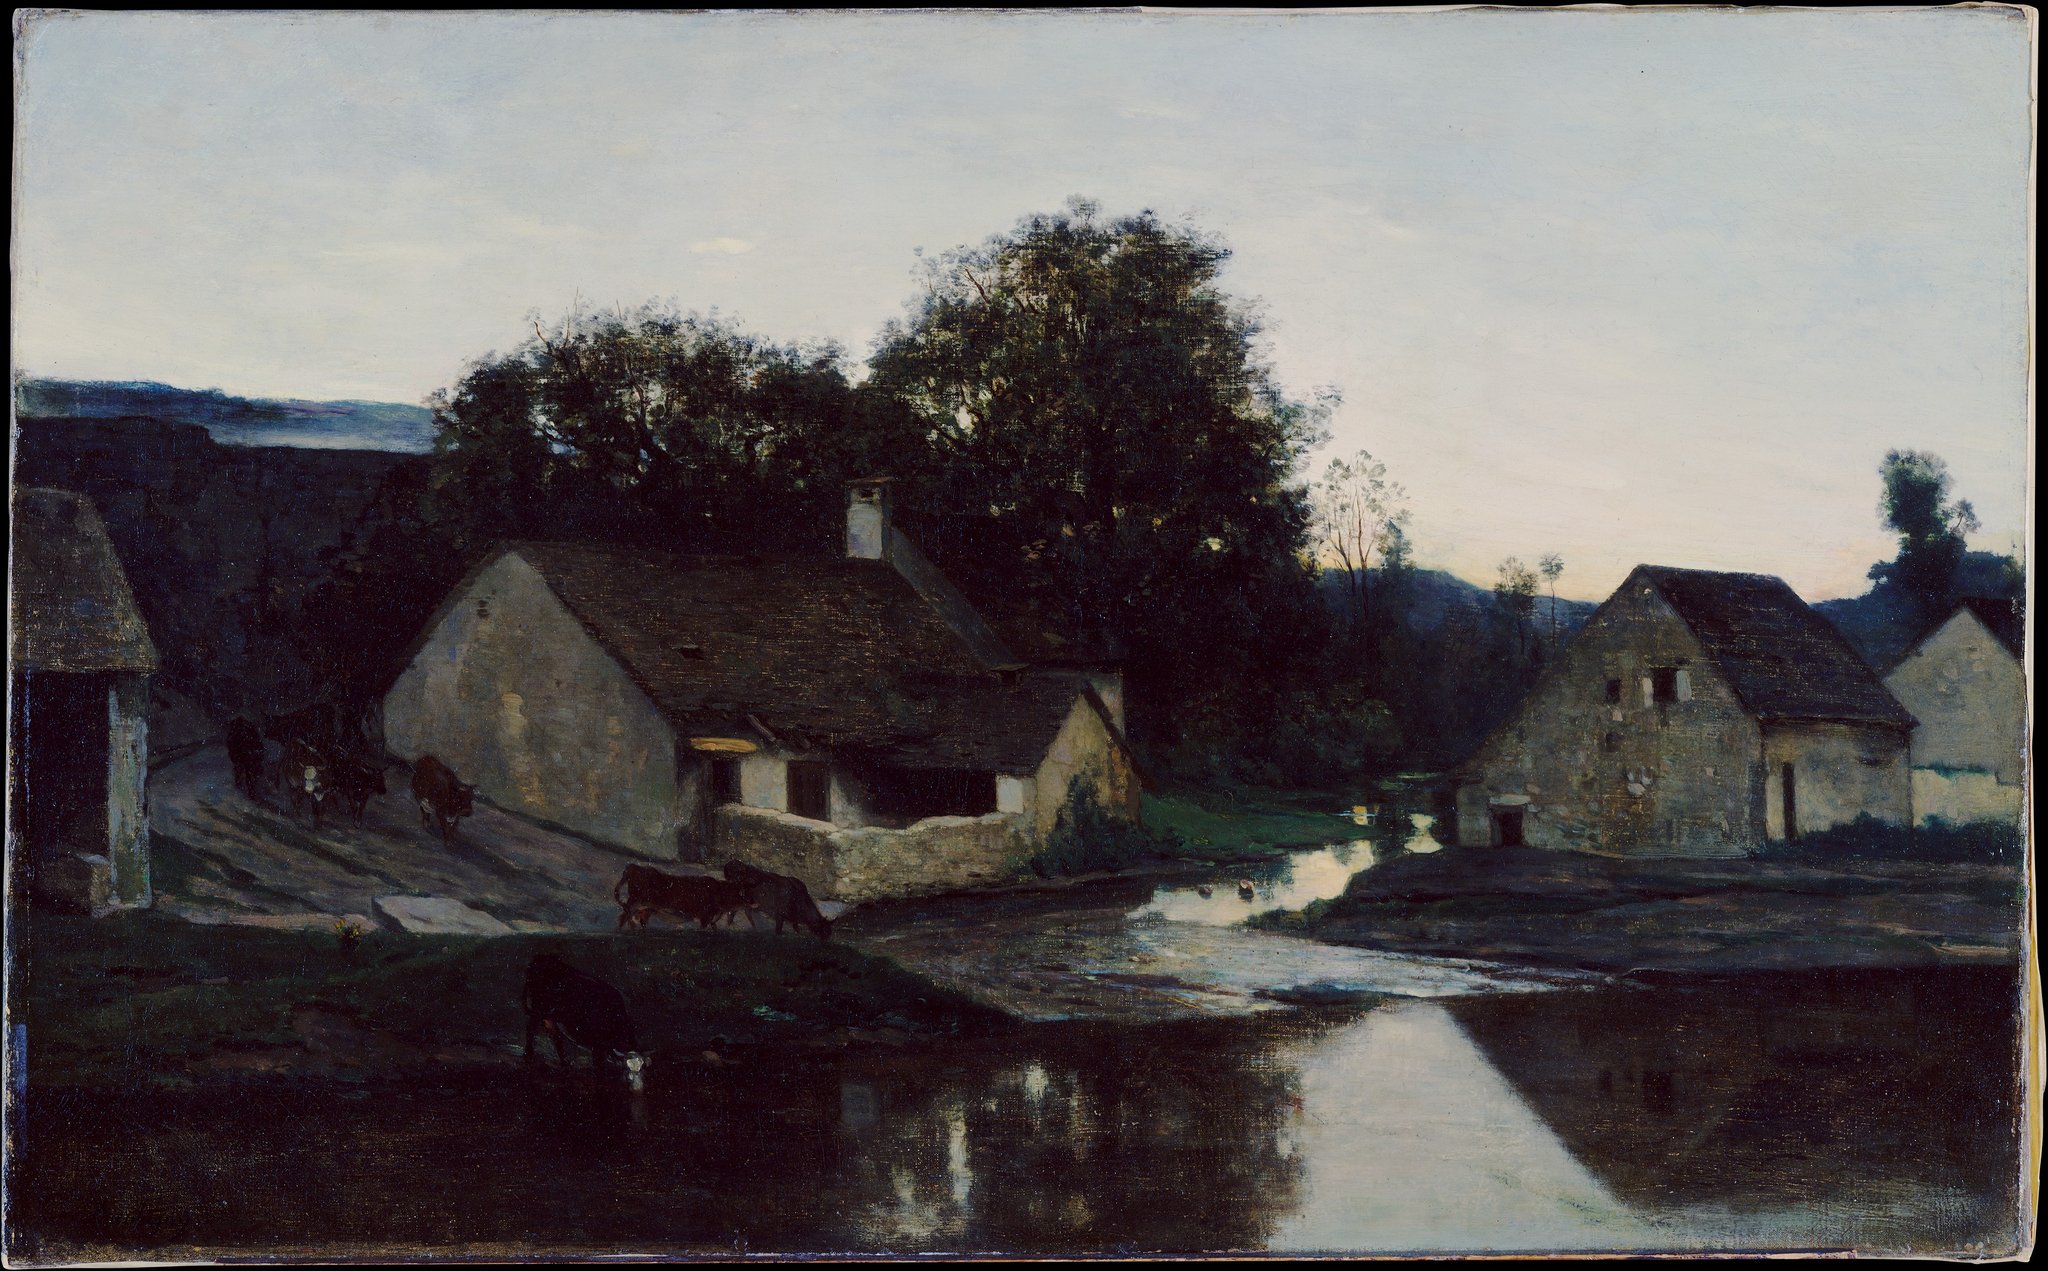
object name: painting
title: The Hamlet of Optevoz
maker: charles-françois daubigny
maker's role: artist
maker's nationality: french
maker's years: 1817-1878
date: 1852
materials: canvas, oil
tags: towns,cows,evening